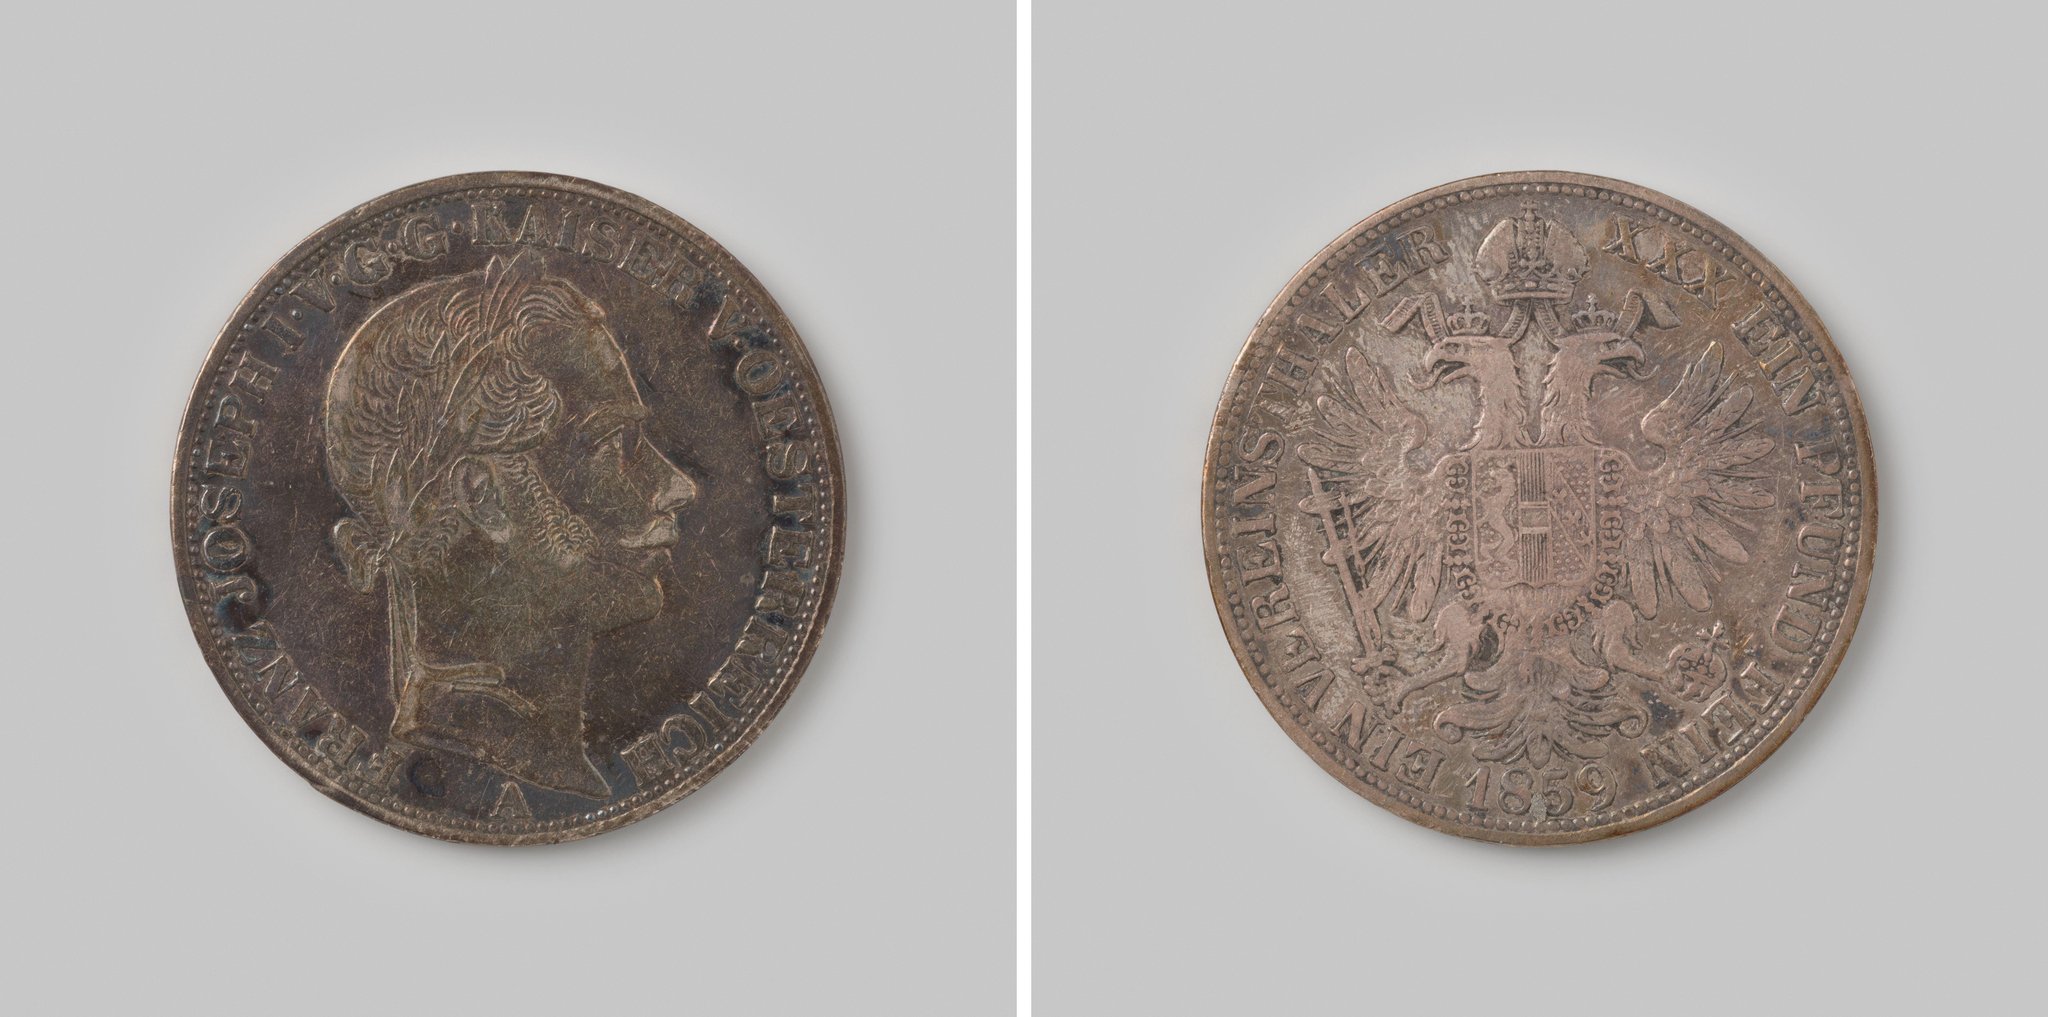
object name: coin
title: Vereinstaler uit het keizerrijk Oostenrijk van Franz Joseph, 1859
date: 1859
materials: silver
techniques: striking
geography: vienna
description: Zilveren munt. Voorzijde: gelauwerd hoofd van de keizer naar rechts, waaronder letter A [=Wenen]. Keerzijde: gekroonde dubbelkoppige adelaar met op de koppen kleine kronen. Op zijn borst door ridderorde met juweel omhangen samengesteld wapenschild en in zijn poten een zwaard en een rijksappel. Waarde-aanduiding als omschrift, jaartal onderaan. Randschrift.